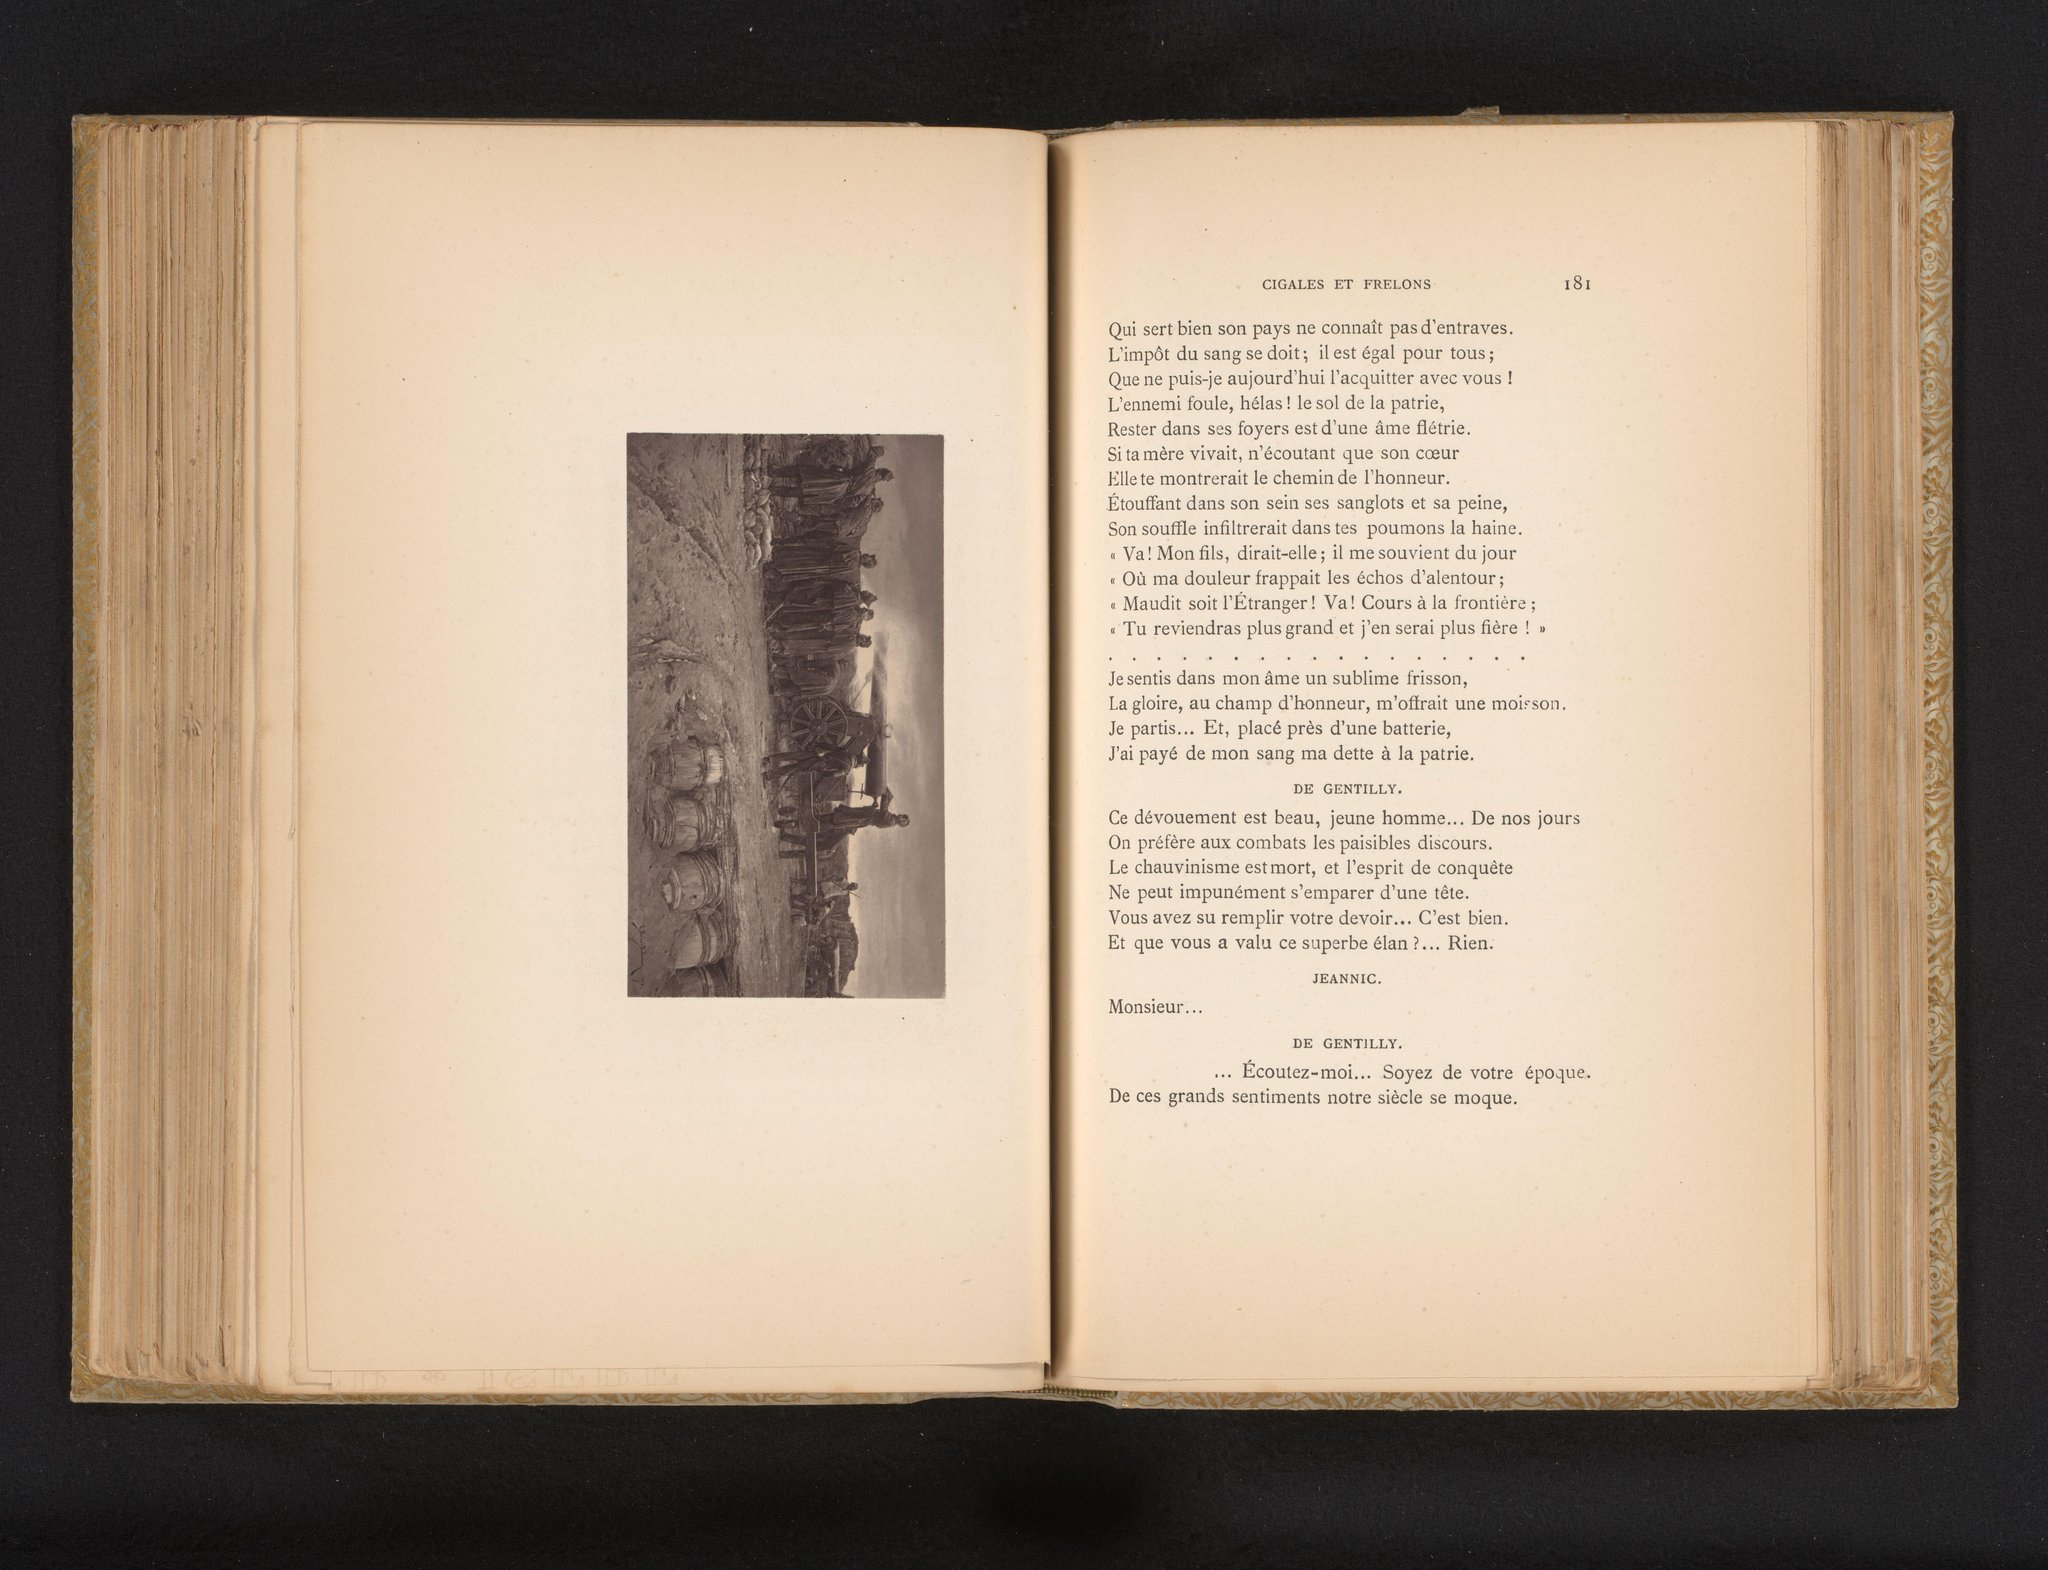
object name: reproduction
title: Fotoreproductie van een schilderij van de frontlinie met kanonnen door Étienne Prosper Berne-Bellecour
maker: Anonymous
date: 1872-1884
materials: paper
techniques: albumen print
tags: firearms: cannon, picture, painting